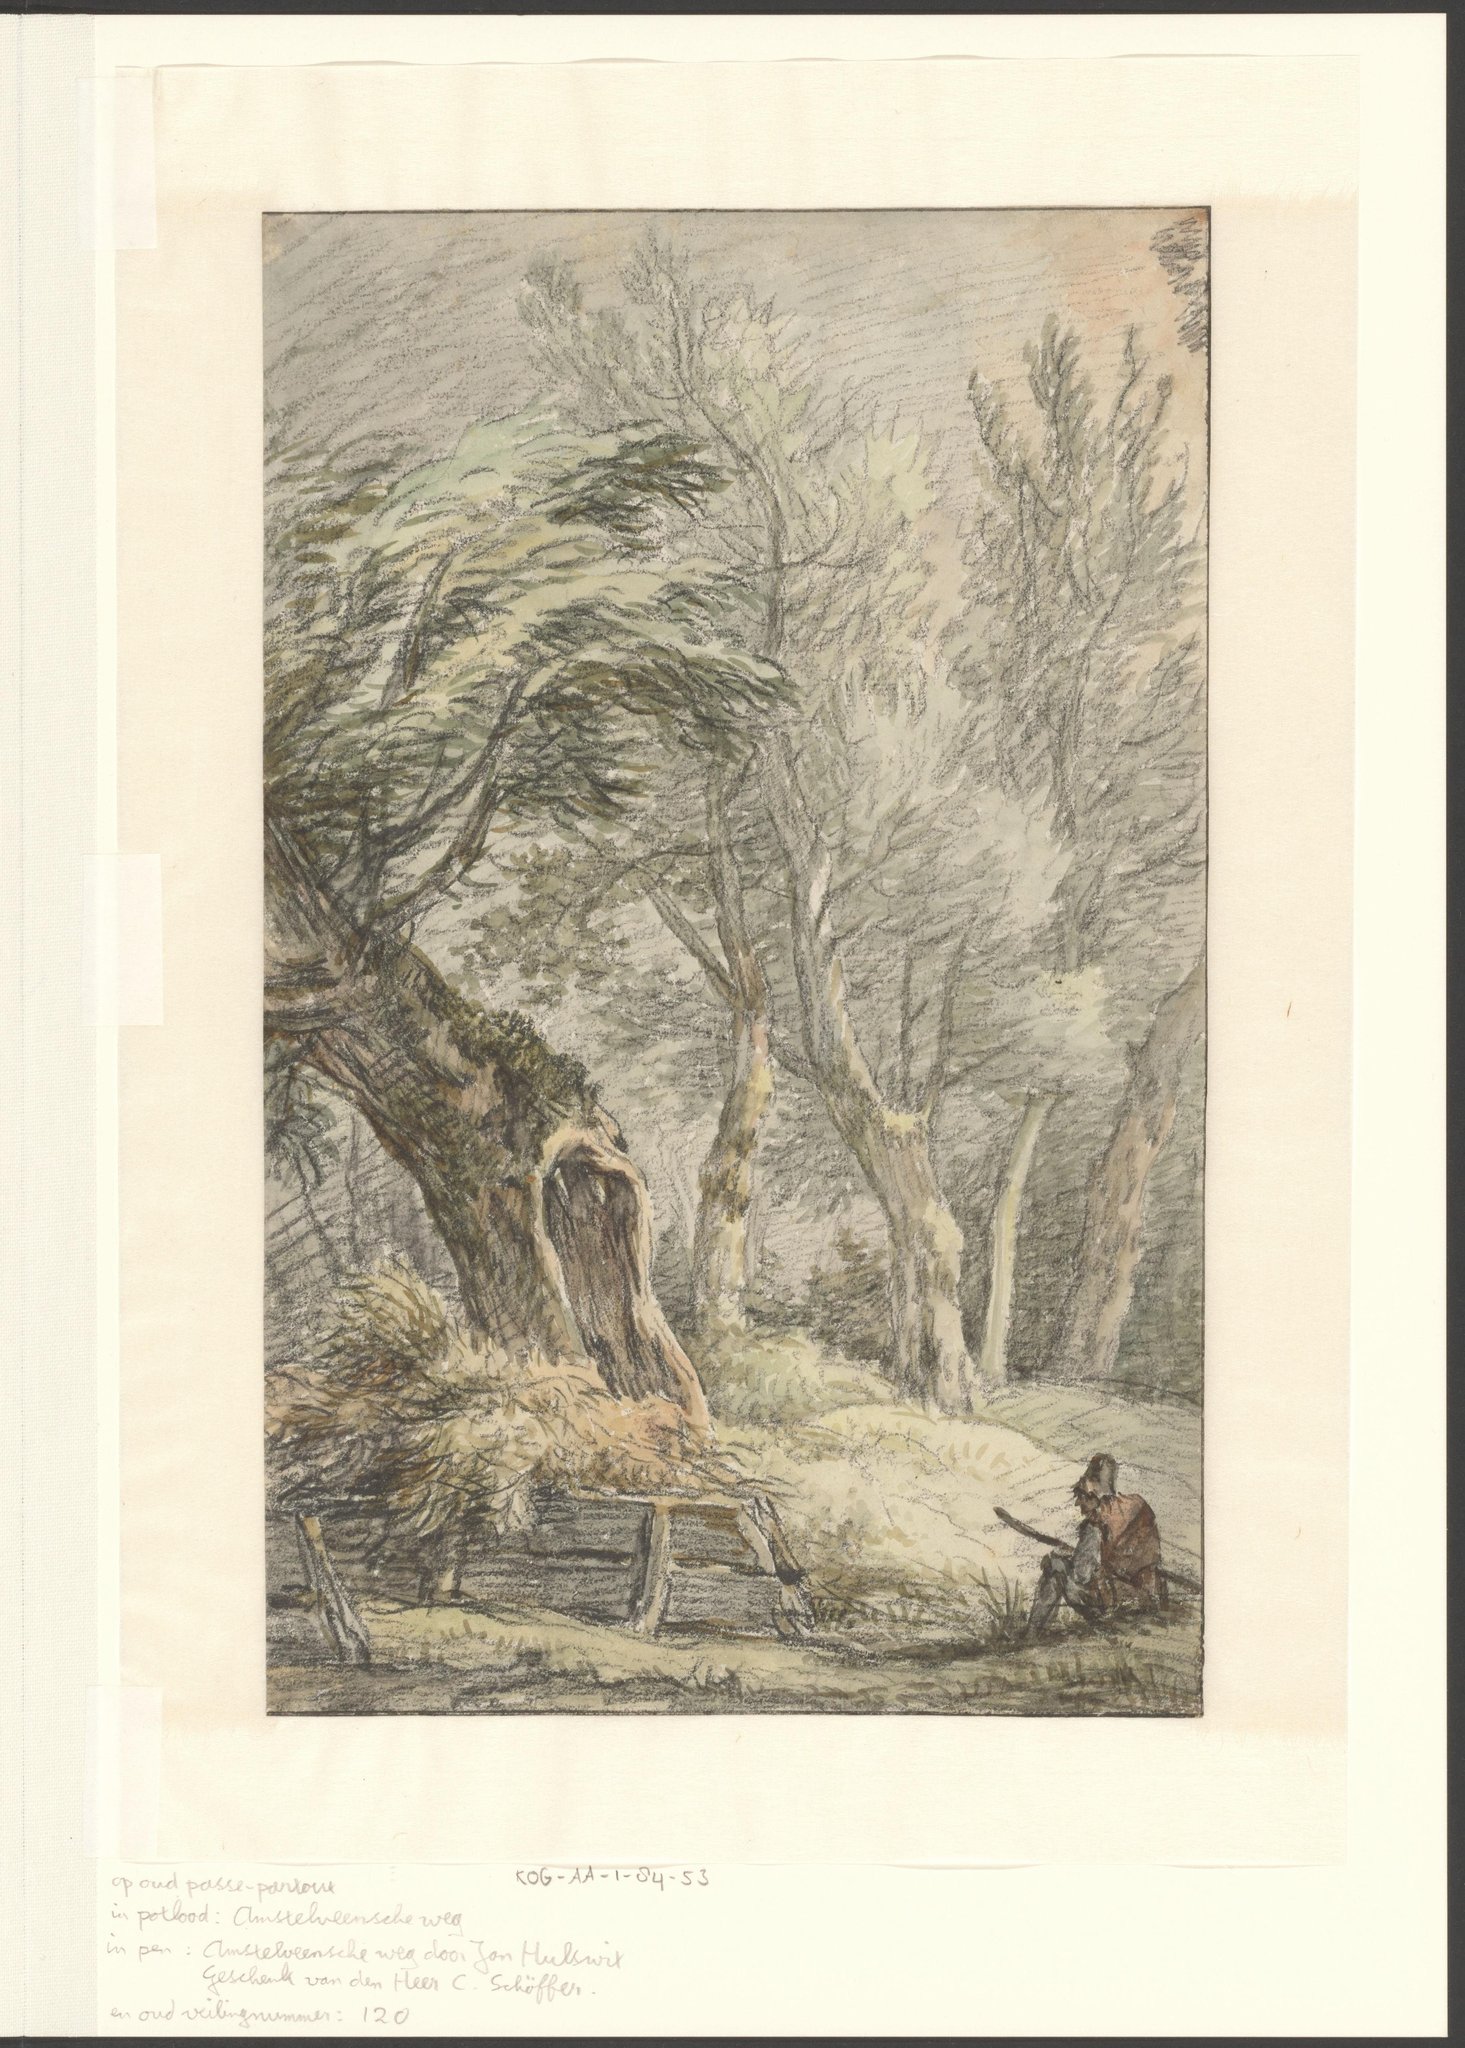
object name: drawing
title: Gezicht op de Amstelveenseweg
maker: jan hulswit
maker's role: draughtsman, painter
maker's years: 1766-1822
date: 1807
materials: chalk, paper, watercolor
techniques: brush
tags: village, road, path, sitting on the ground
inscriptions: signature, date and inscription: ‘direkt naar 't Leeven / op de Amstelveense Weh. / J: Hulsewit. 1807. I: 25 Sept: 1815’, inscription: ‘op oud passe-partout (...) oud veilingnummer: 120’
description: Onderwerpsrubriek binnen de Atlas Amsterdam: Amstelveenseweg.